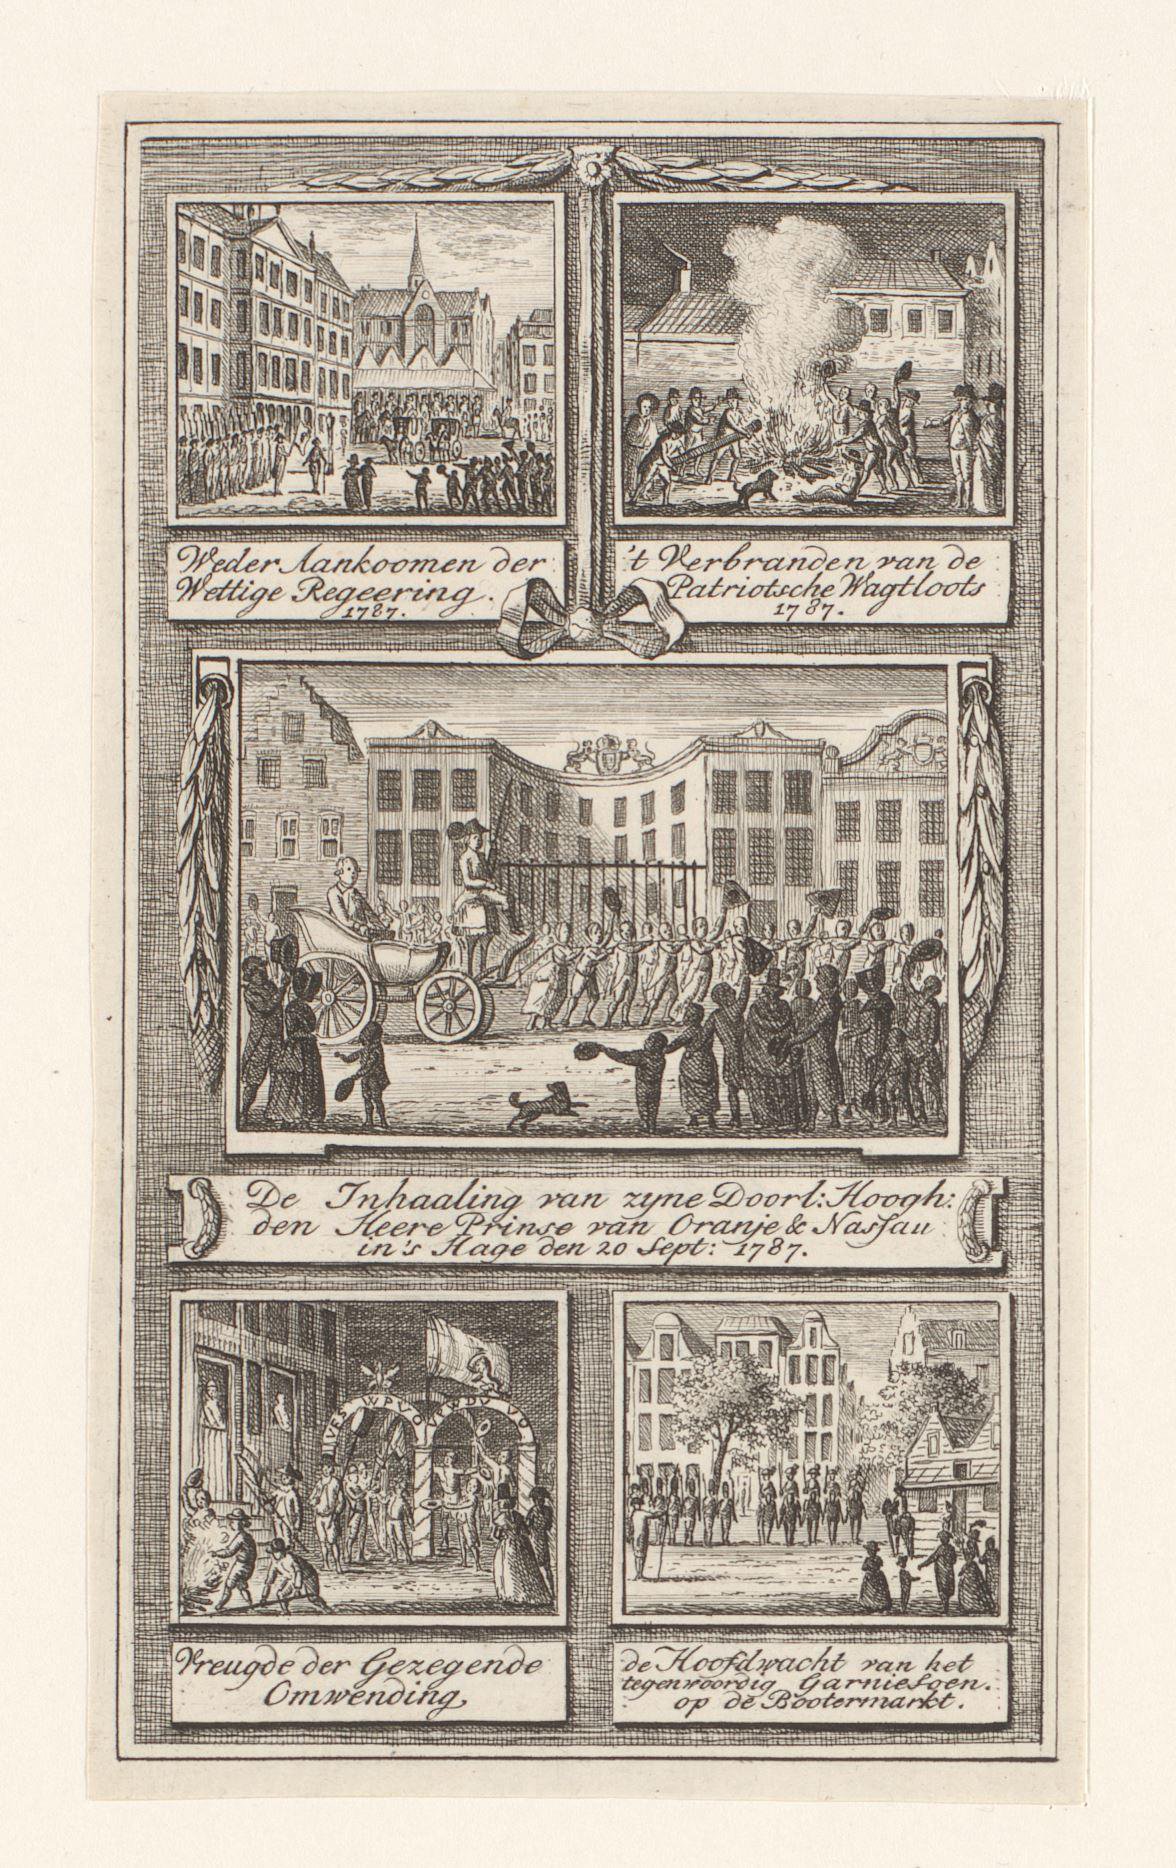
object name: print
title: Herstel van de stadhouder, 1787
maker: Anonymous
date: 1787-1789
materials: paper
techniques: etching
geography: northern netherlands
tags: the hague, william v (prince of orange), public festivities at other royal events, not meant or mentioned above, open fire (in general), four-wheeled, animal-drawn vehicle, e.g.: cab, carriage, coach, amsterdam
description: Blad met vijf voorstellingen rond het herstel van de stadhouder in 1787 in Den Haag en Amsterdam. Centraal de inhaling van de prins van Oranje door de burgerij van Den Haag op 20 september 1787.